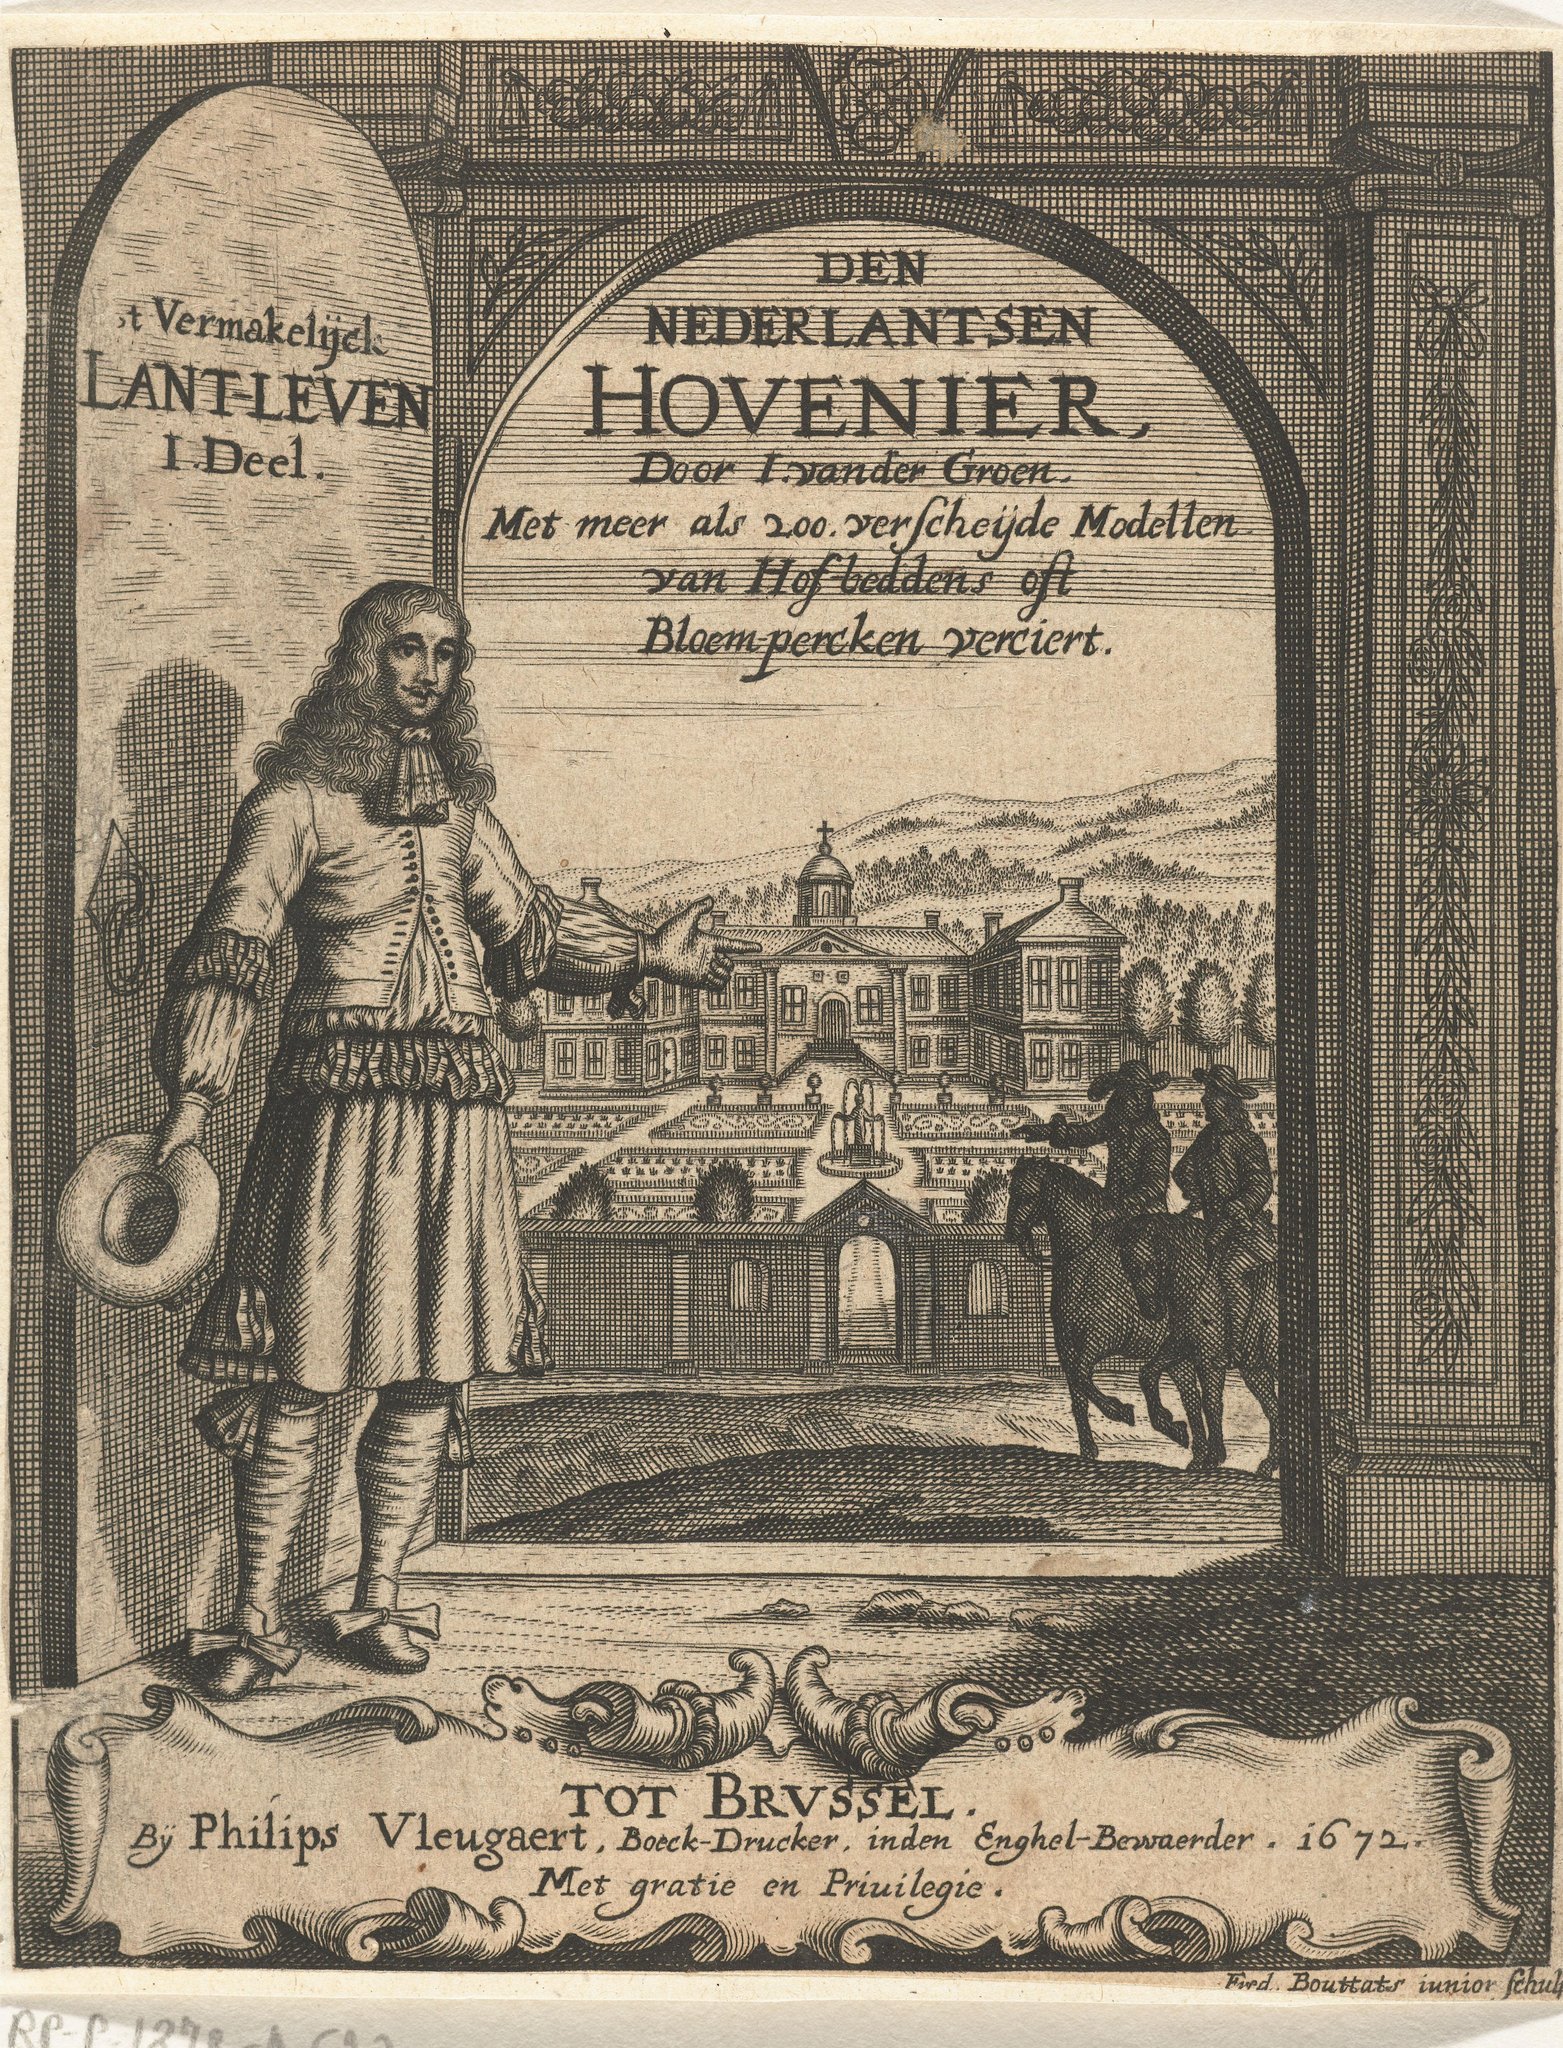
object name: print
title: De Nederlantsen Hovenier, 't Vermakelijck Lant-leven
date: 1672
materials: paper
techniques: engraving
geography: brussels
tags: horticulture, vegetable culture, market gardening, french or architectonic garden; formal garden, gardening, inner court of palace or 'hôtel'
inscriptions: collector's mark: Lugt 2228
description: De titelpagina van het eerste boek van 'Den Nederlantsen Hovenier' door Jan van der Groen, de tuinier van Willem III van Oranje. Een hofdienaar staat voor een open poort en wijst naar de achtergrond. Door de poort kijkt men uit op een grote, architectonische hoftuin en een paleis. Twee ruiters rijden richting de poort. In een cartouche onder de prent gegevens over de druk..